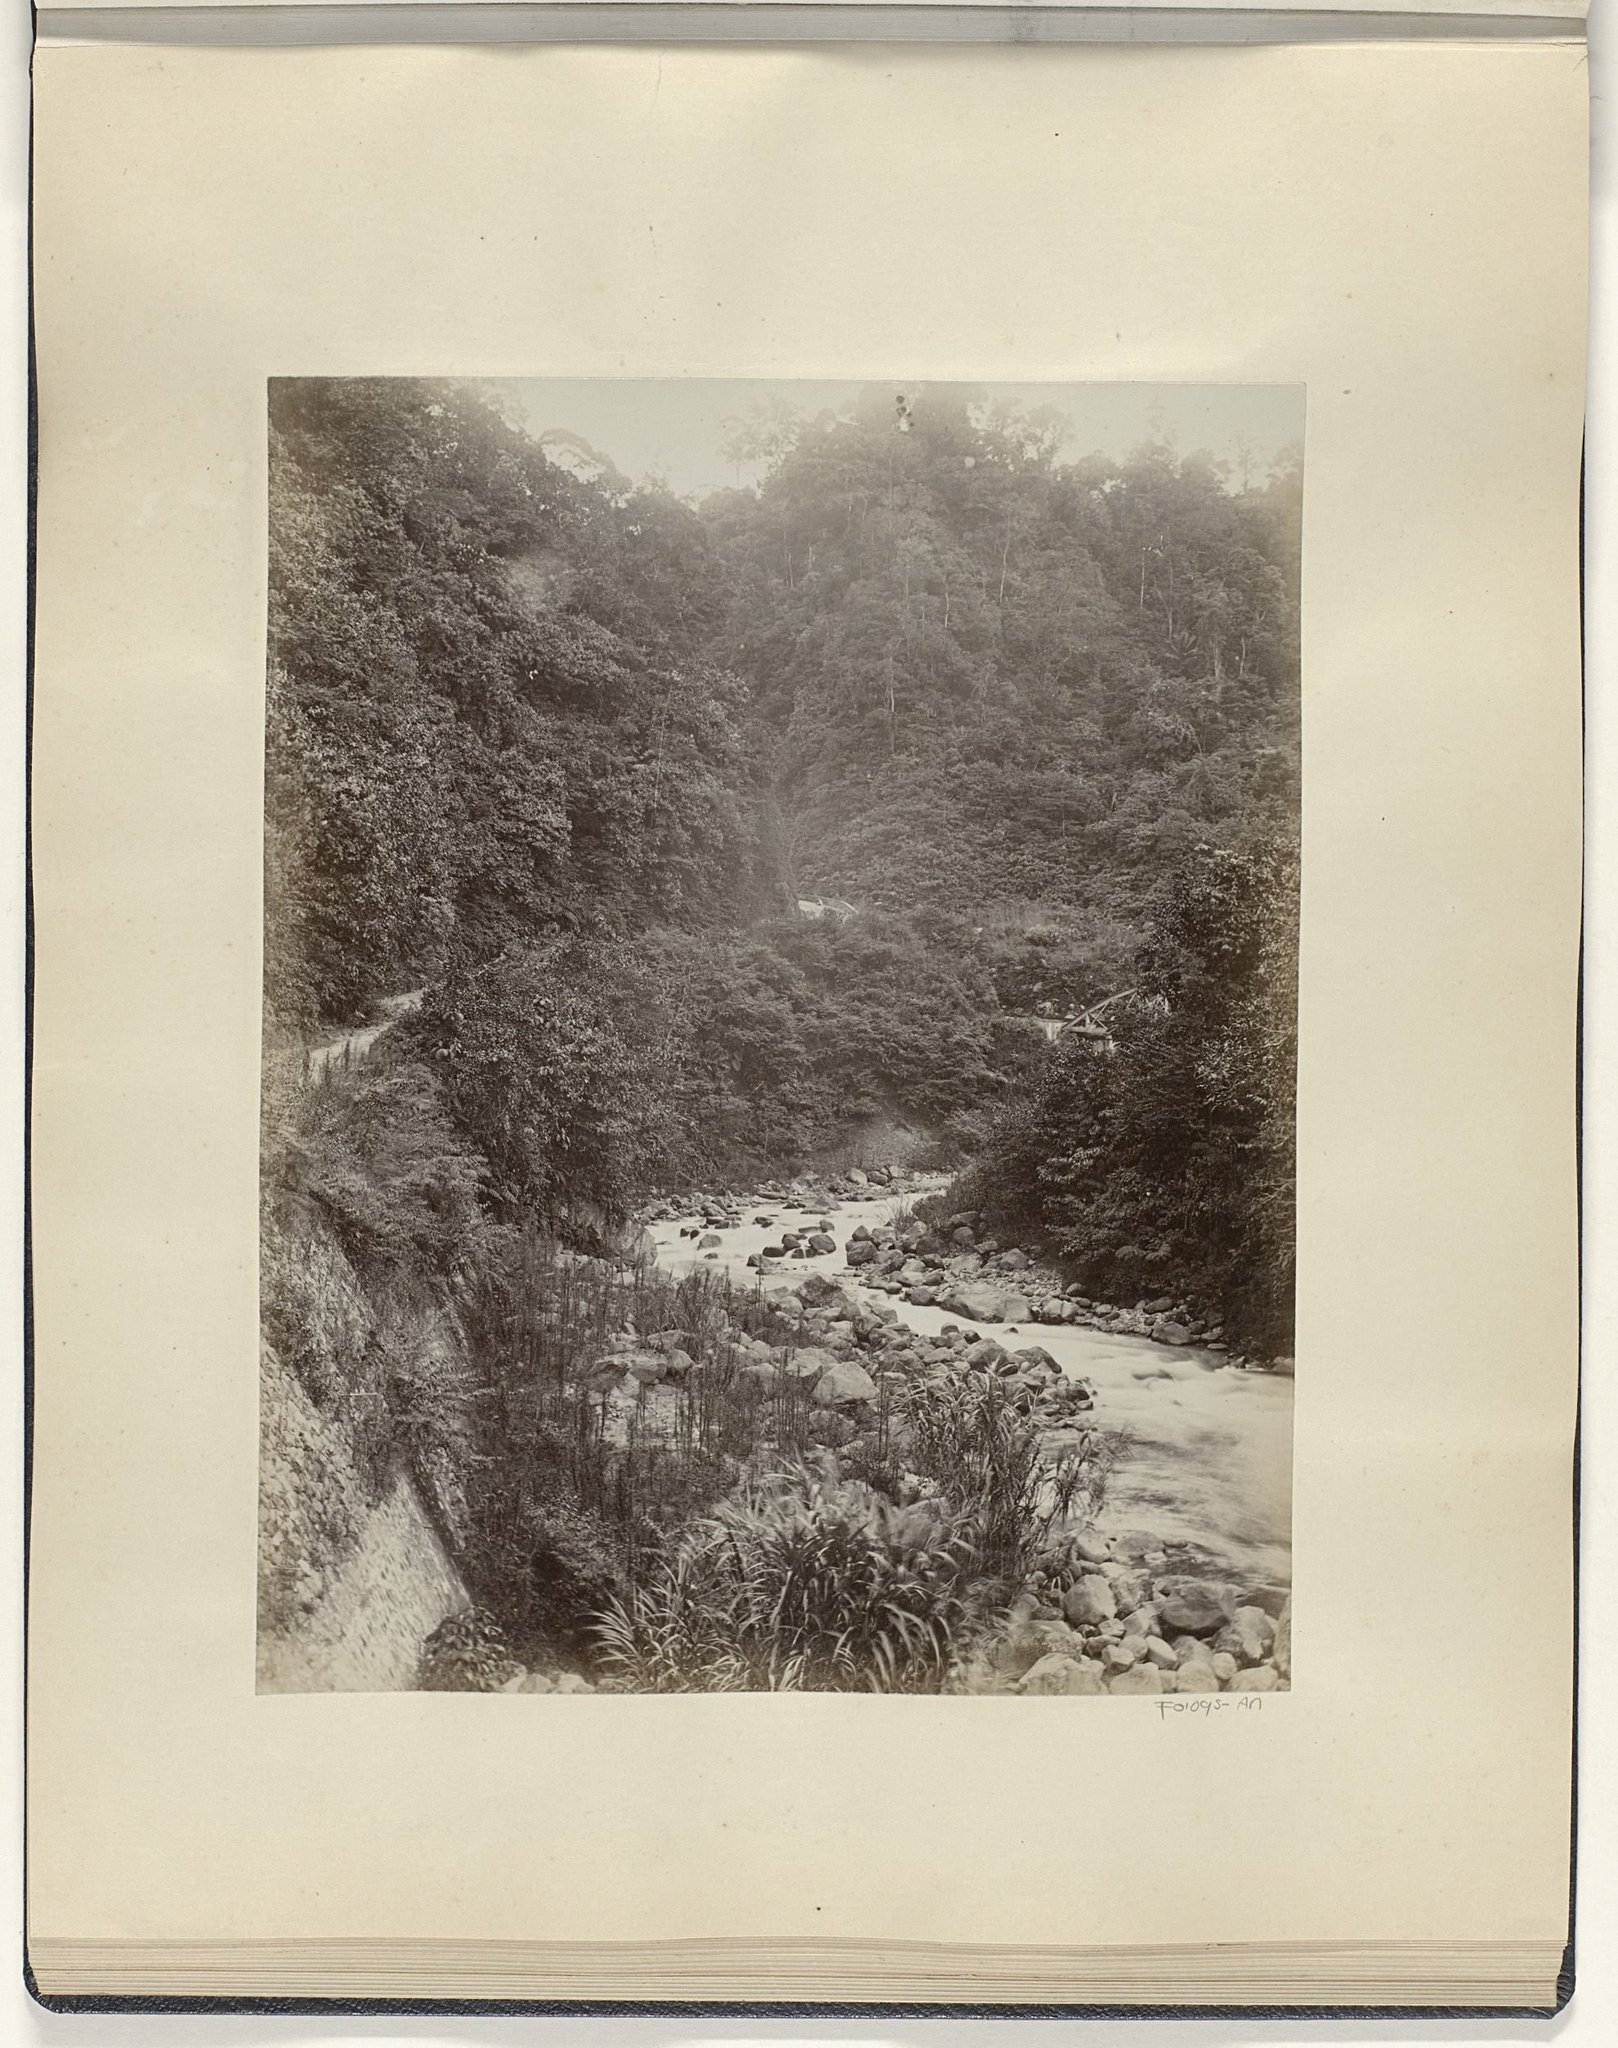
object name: photograph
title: Beek in een oerwoud, mogelijk op Sumatra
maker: Anonymous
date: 1895-1905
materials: paper, photographic support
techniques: albumen print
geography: sumatra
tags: brook, sumatra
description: Onderdeel van Reisalbum met foto's van bezienswaardigheden in Italië, Zwitserland en Nederlands-Indië.